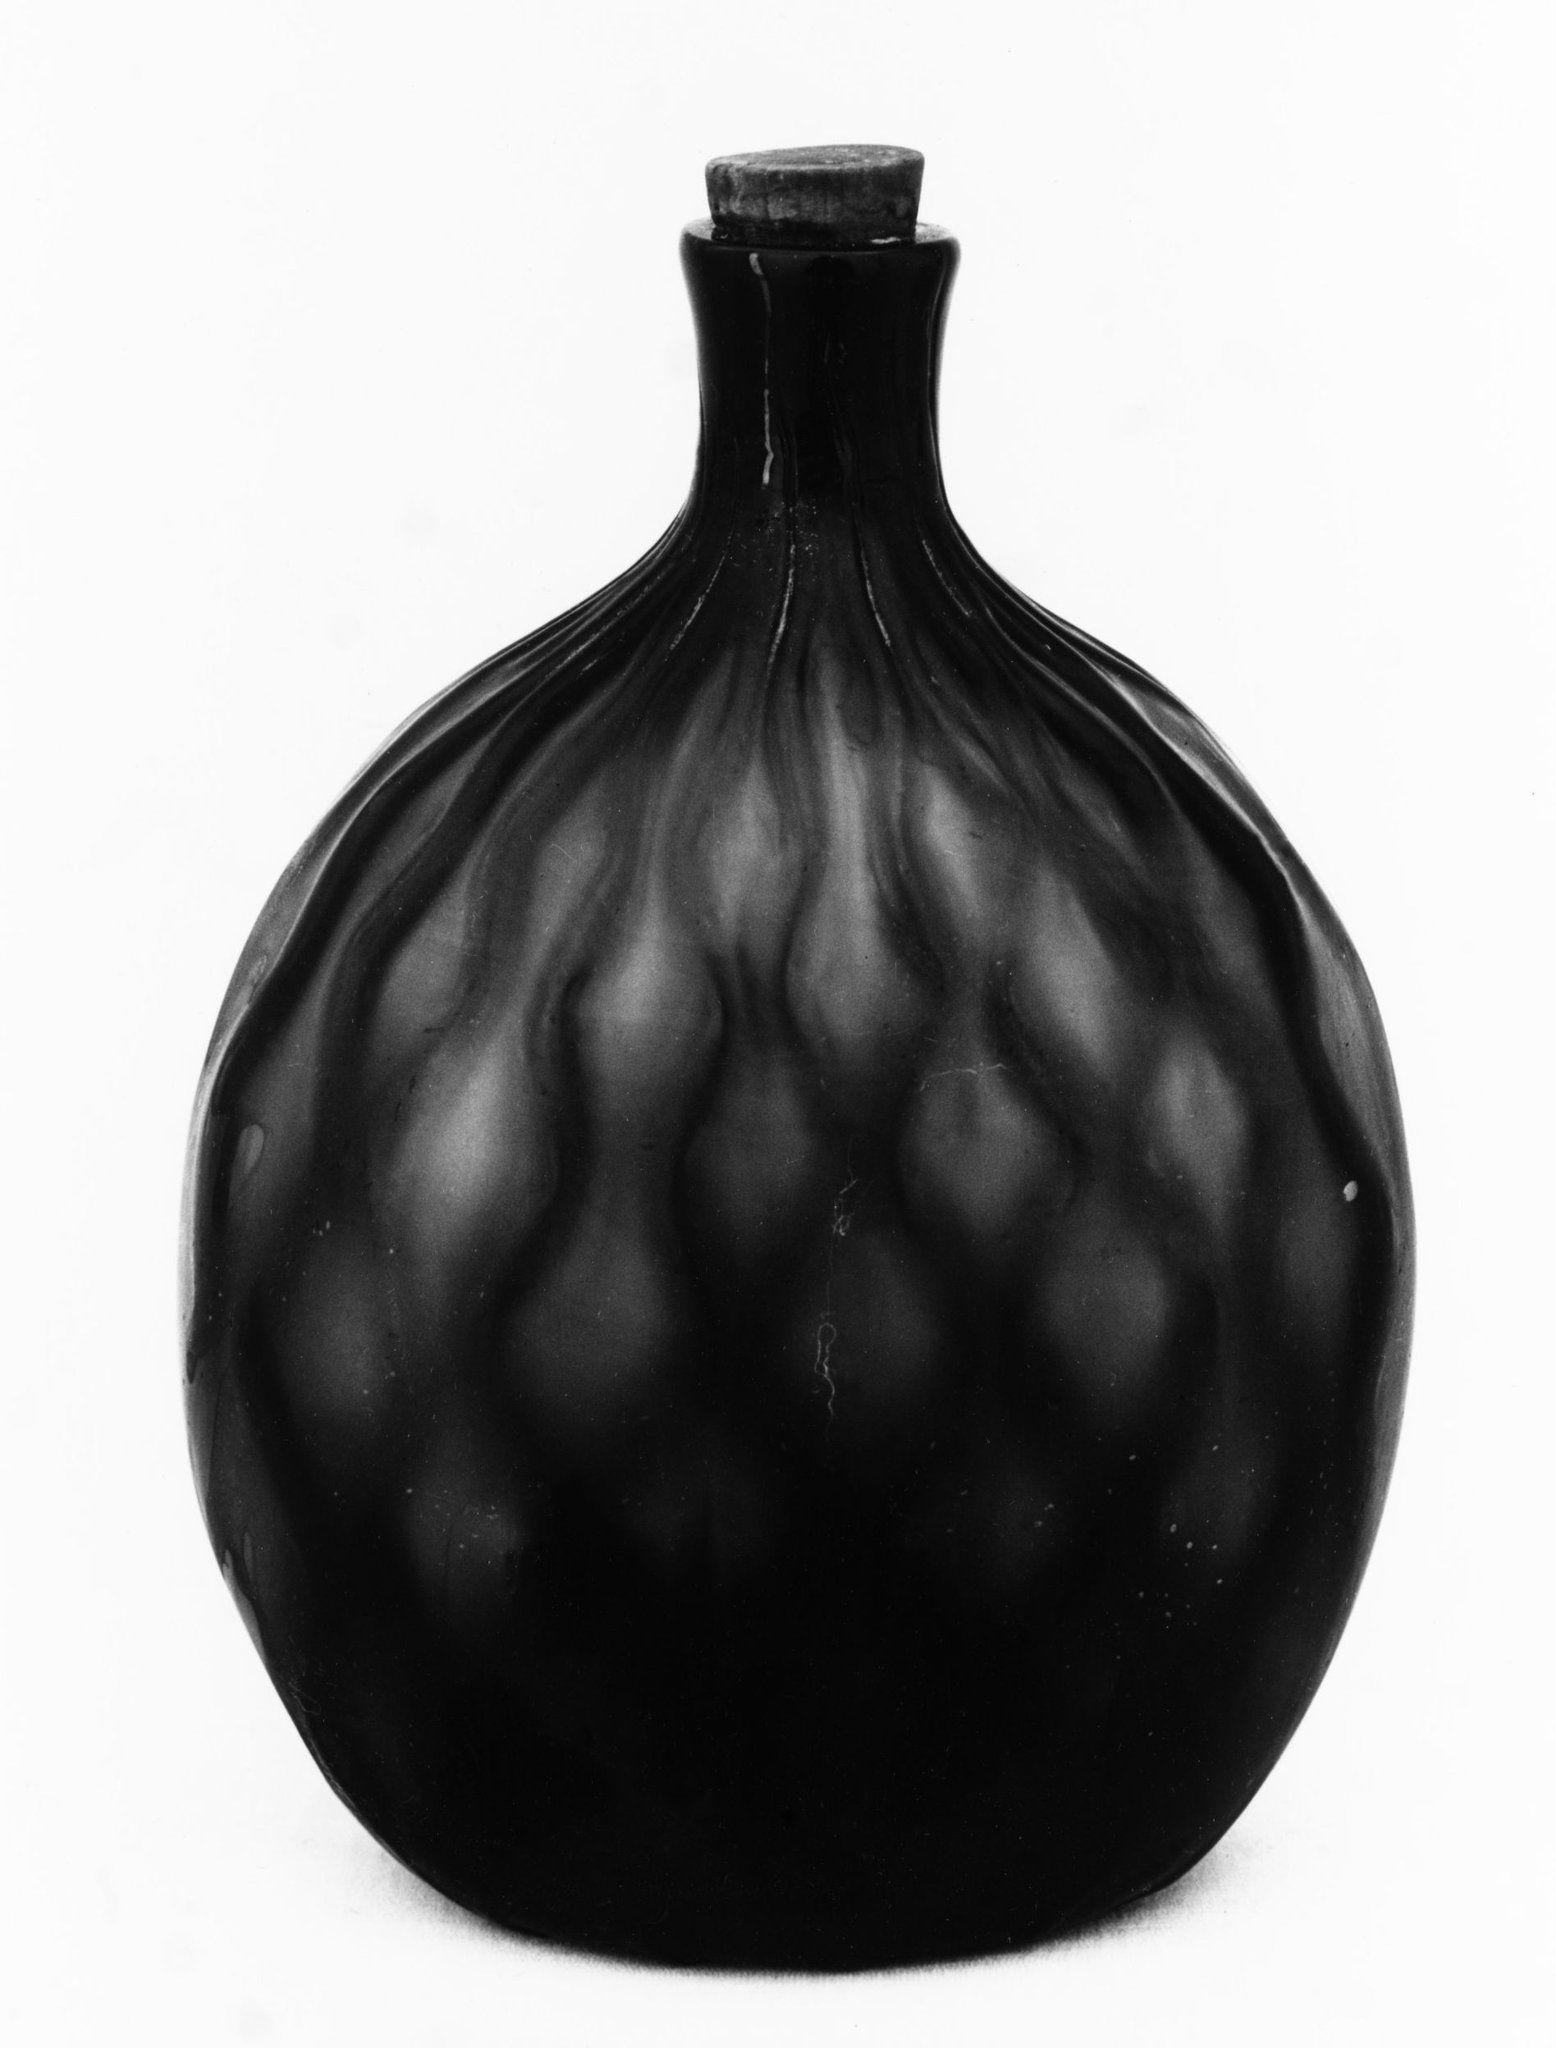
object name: flask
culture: american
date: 1770-1800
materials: glass, lead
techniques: glassblowing, molding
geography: united states